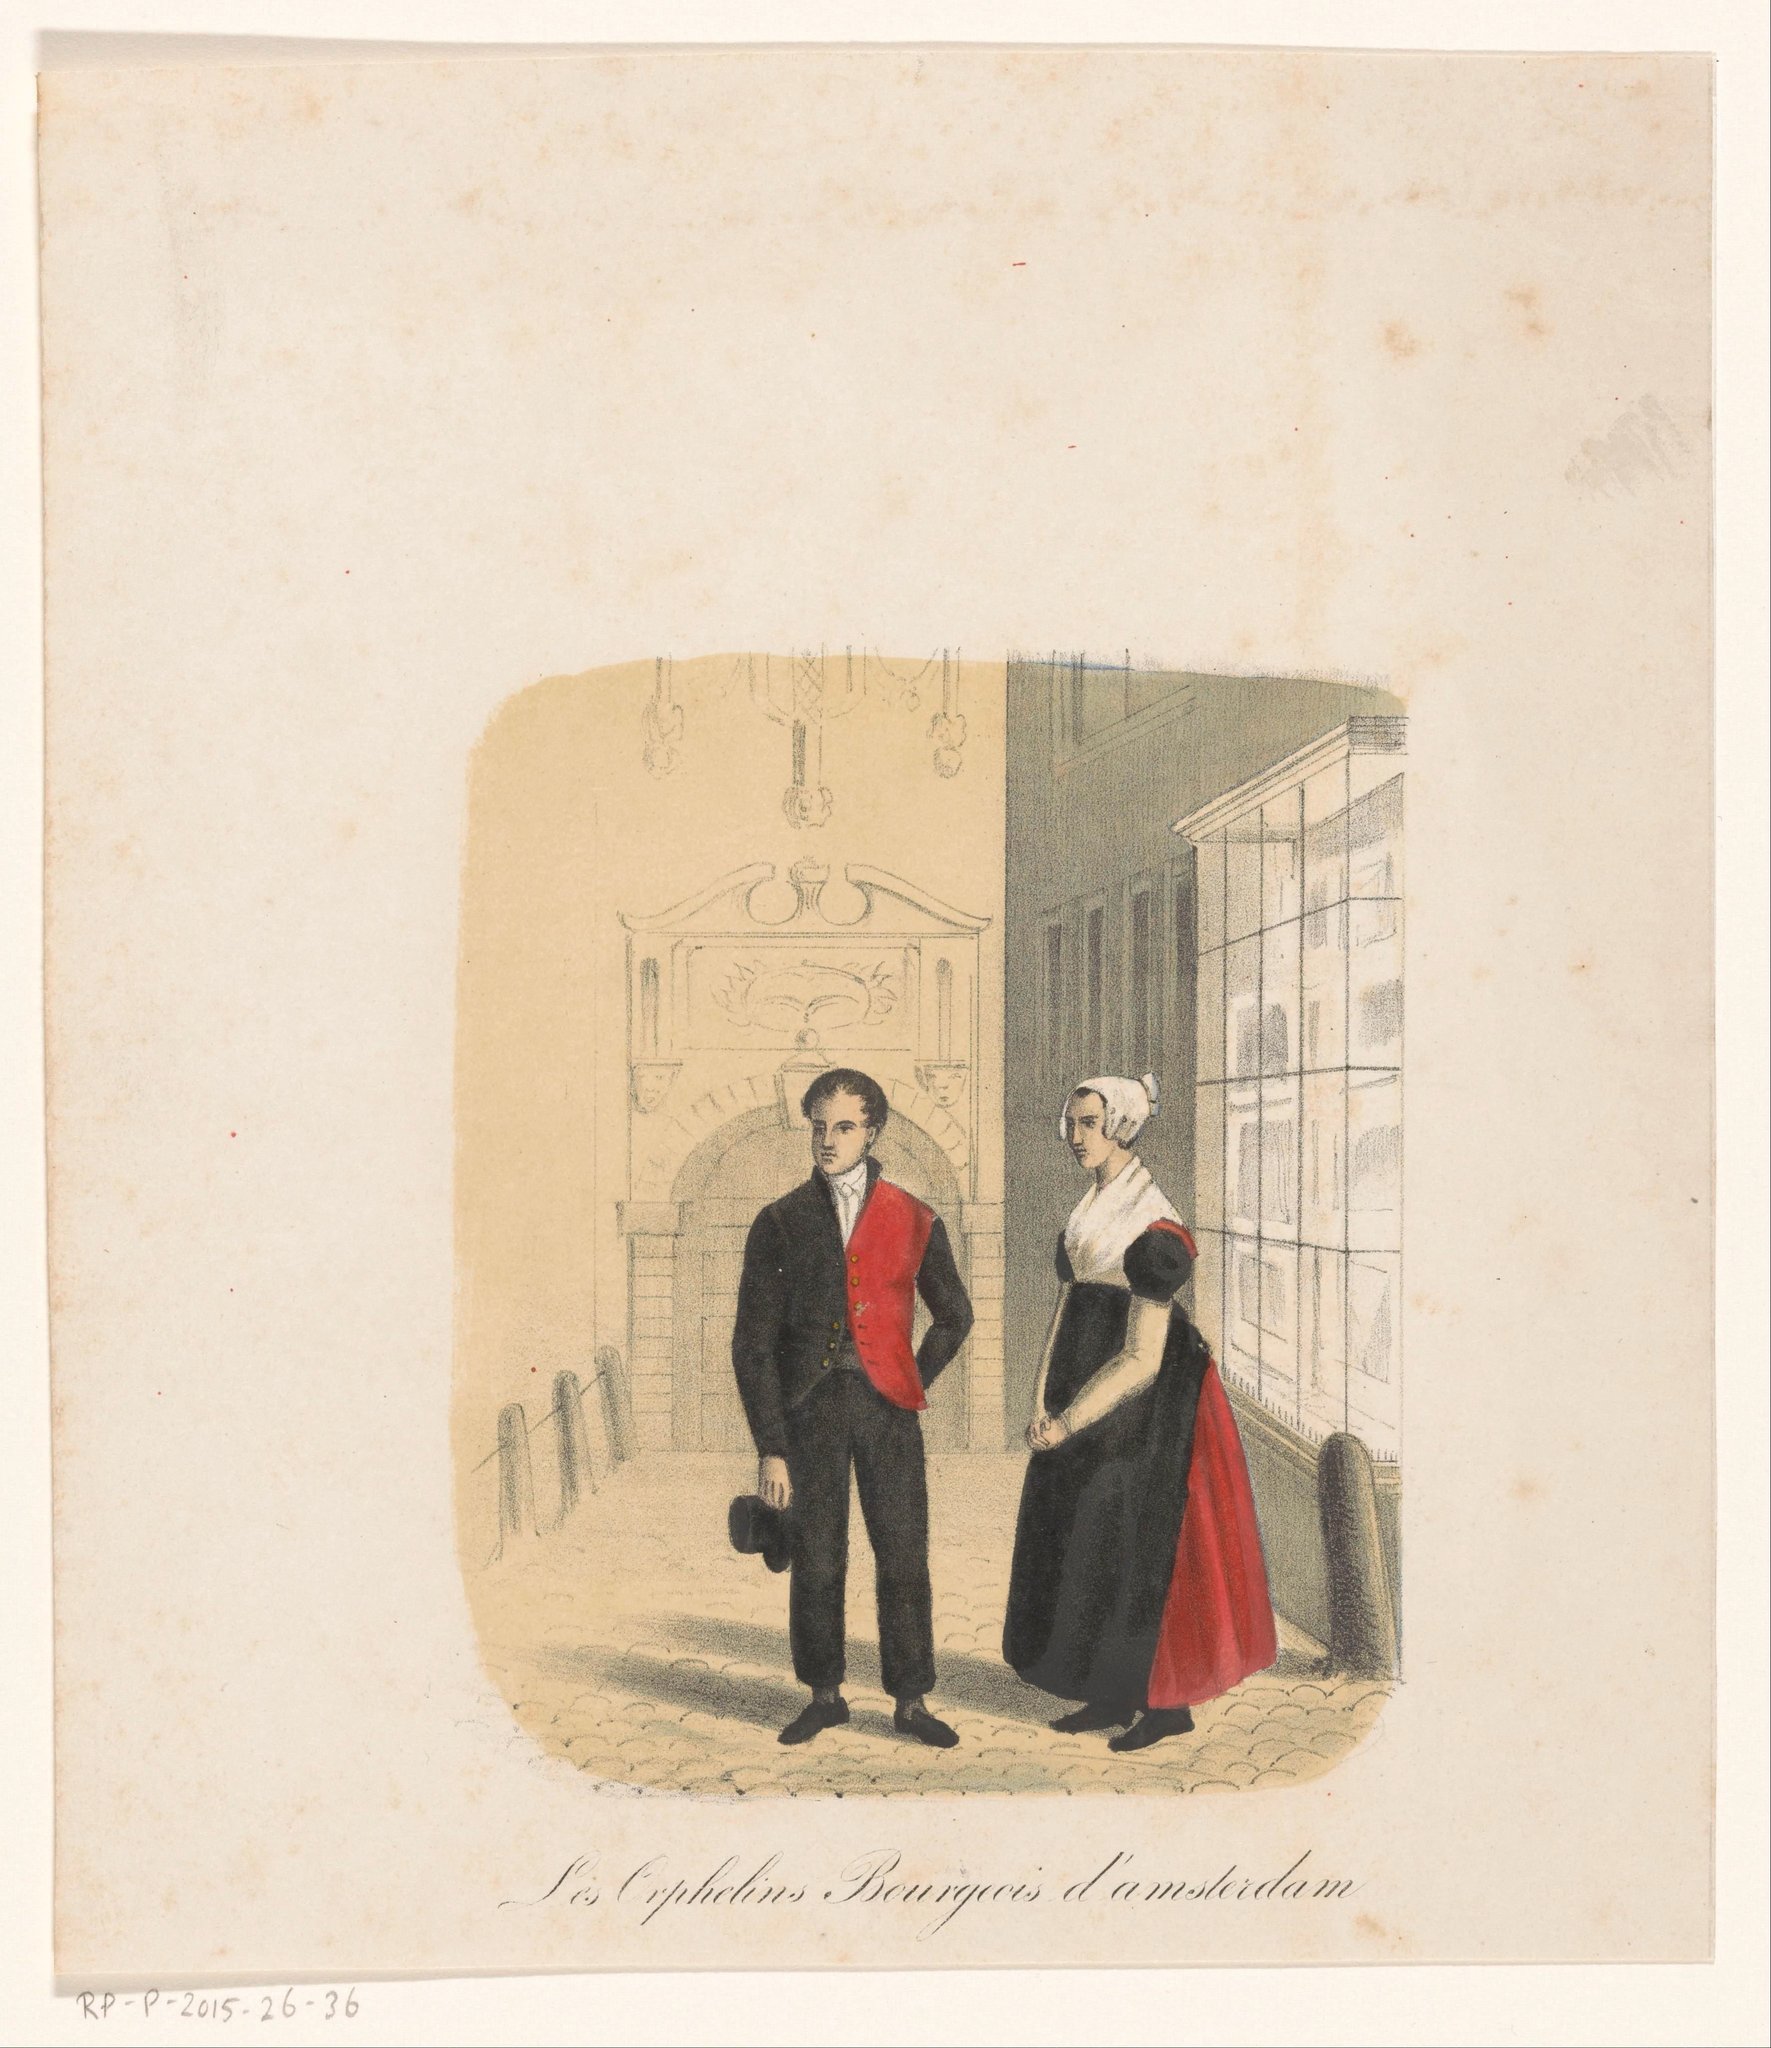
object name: print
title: Les Orphelins Bourgeois d'amsterdam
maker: Anonymous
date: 1850-1899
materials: paper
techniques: hand coloring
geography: amsterdam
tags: art dealer, orphans, shop-window, show-window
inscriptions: collector's mark: Lugt 2228, collector's mark: Lugt 4779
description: Twee weeskinderen voor de etalage van kunsthandel Frans Buffa & Zonen, voor de poort van het burgerweeshuis te Amsterdam.